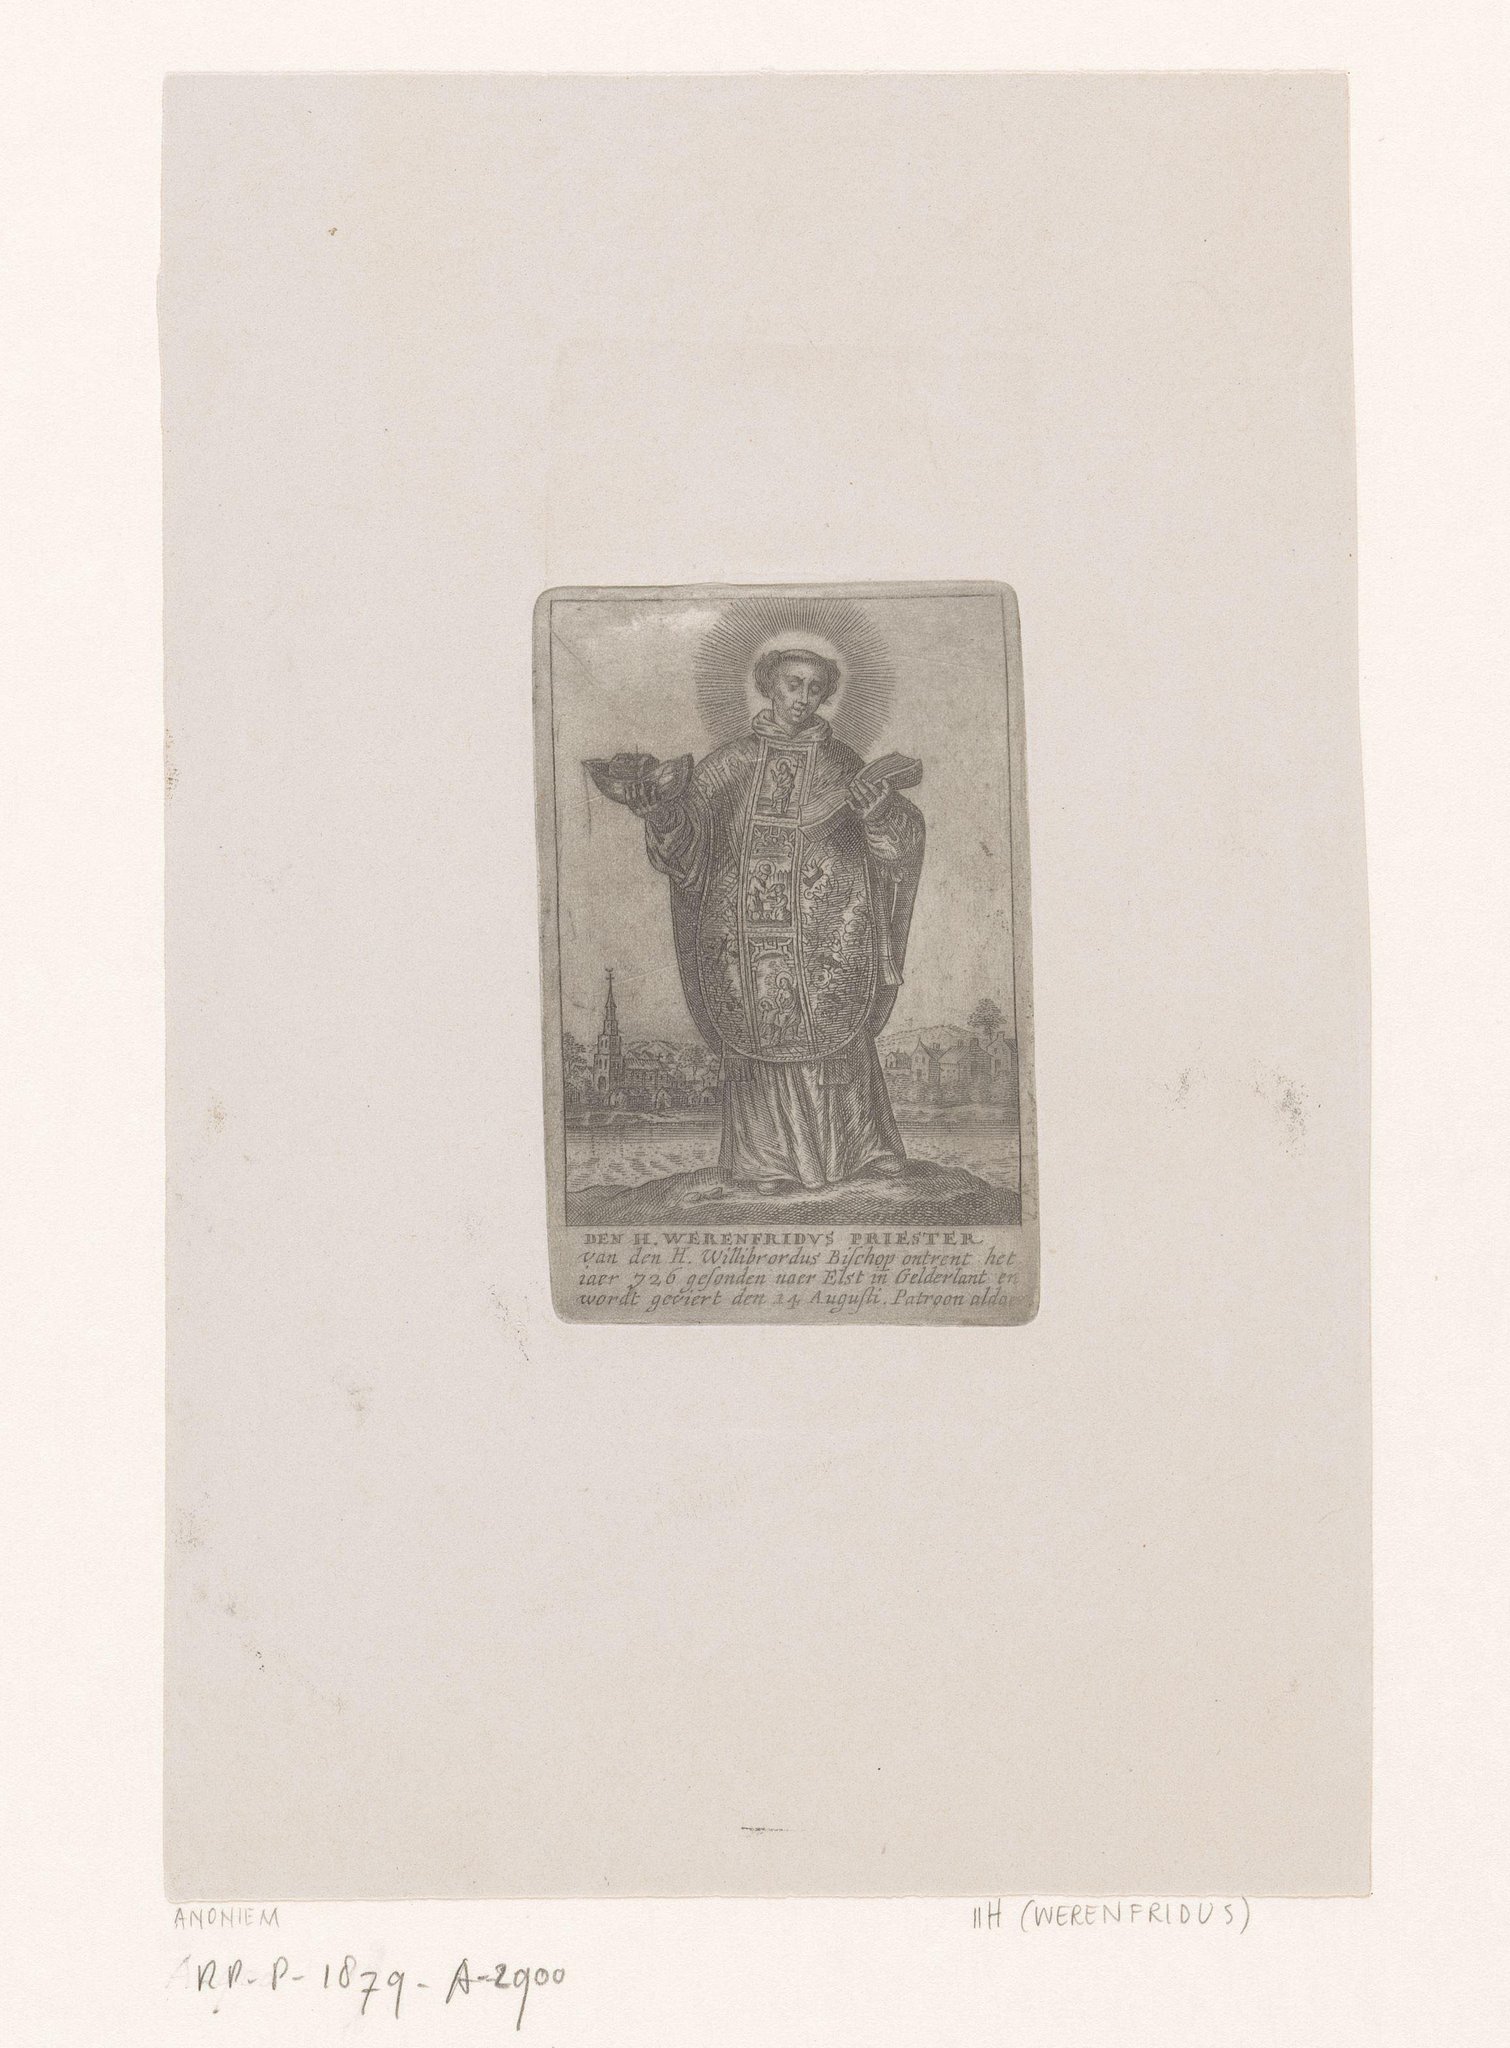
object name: print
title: H. Werenfridus van Elst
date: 1700-1799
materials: paper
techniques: engraving, intaglio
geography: netherlands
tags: male saints (werenfridus)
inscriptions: collector's mark: Lugt 2228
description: Dit betreft een moderne druk van een oude plaat.